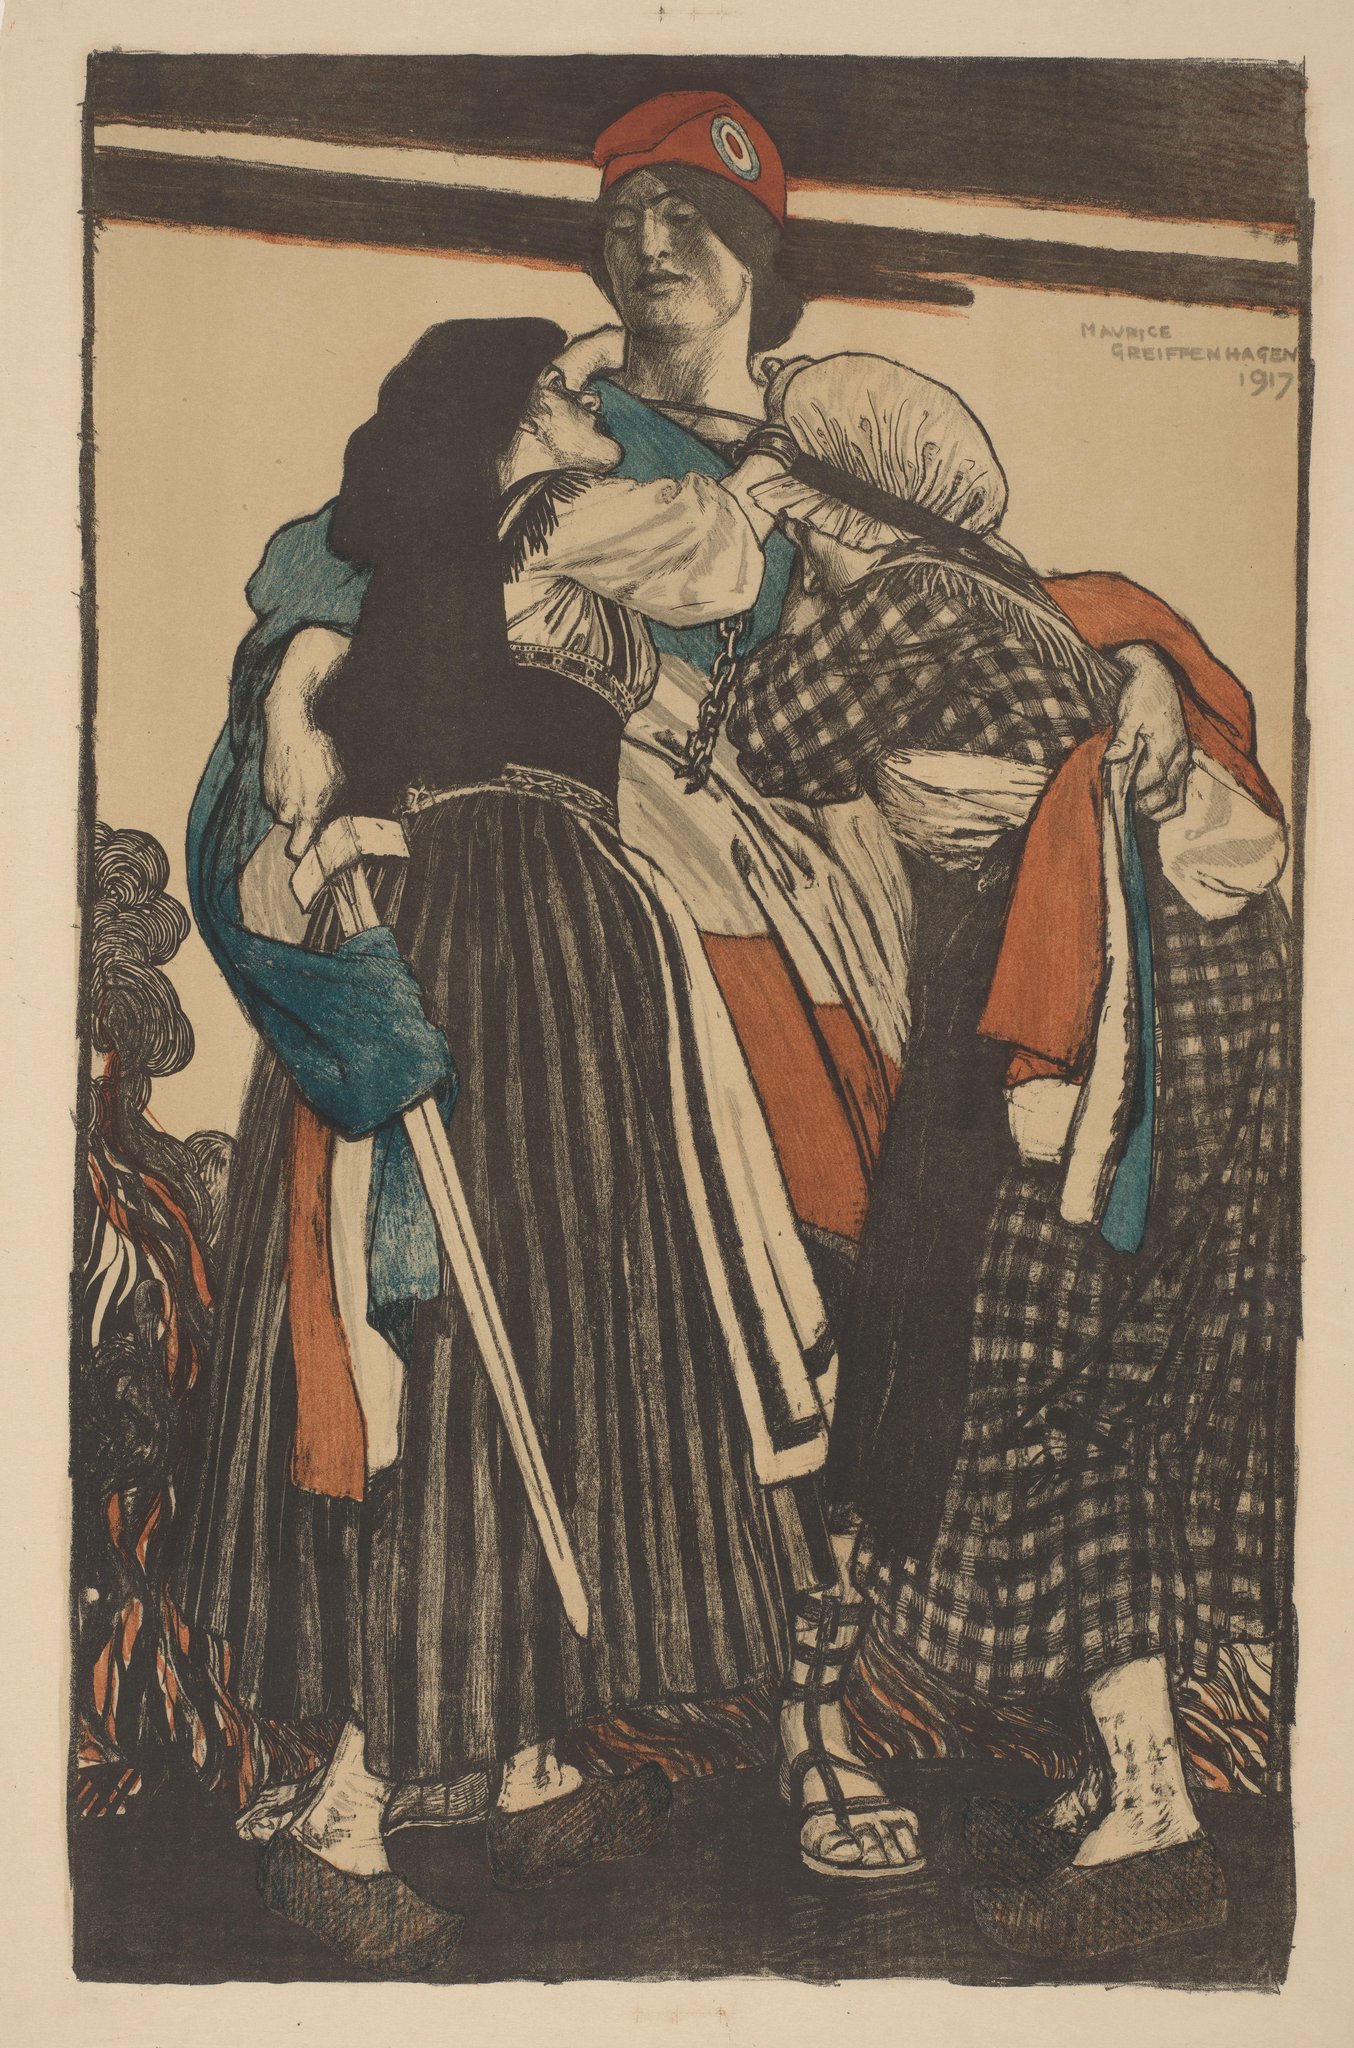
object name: print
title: Vrouw met zwaard omarmt twee kinderen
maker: maurice william greiffenhagen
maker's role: painter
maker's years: 1862-1931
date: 1917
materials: paper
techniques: lithograph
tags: adult woman, embracing each other, kissing, war, child (at home)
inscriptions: collector's mark: Lugt 2166, collector's mark: Lugt 2166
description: Deze prent behoort tot de reeks 'Ideals' binnen de serie 'The Great War: Britain’s Efforts and Ideals'.